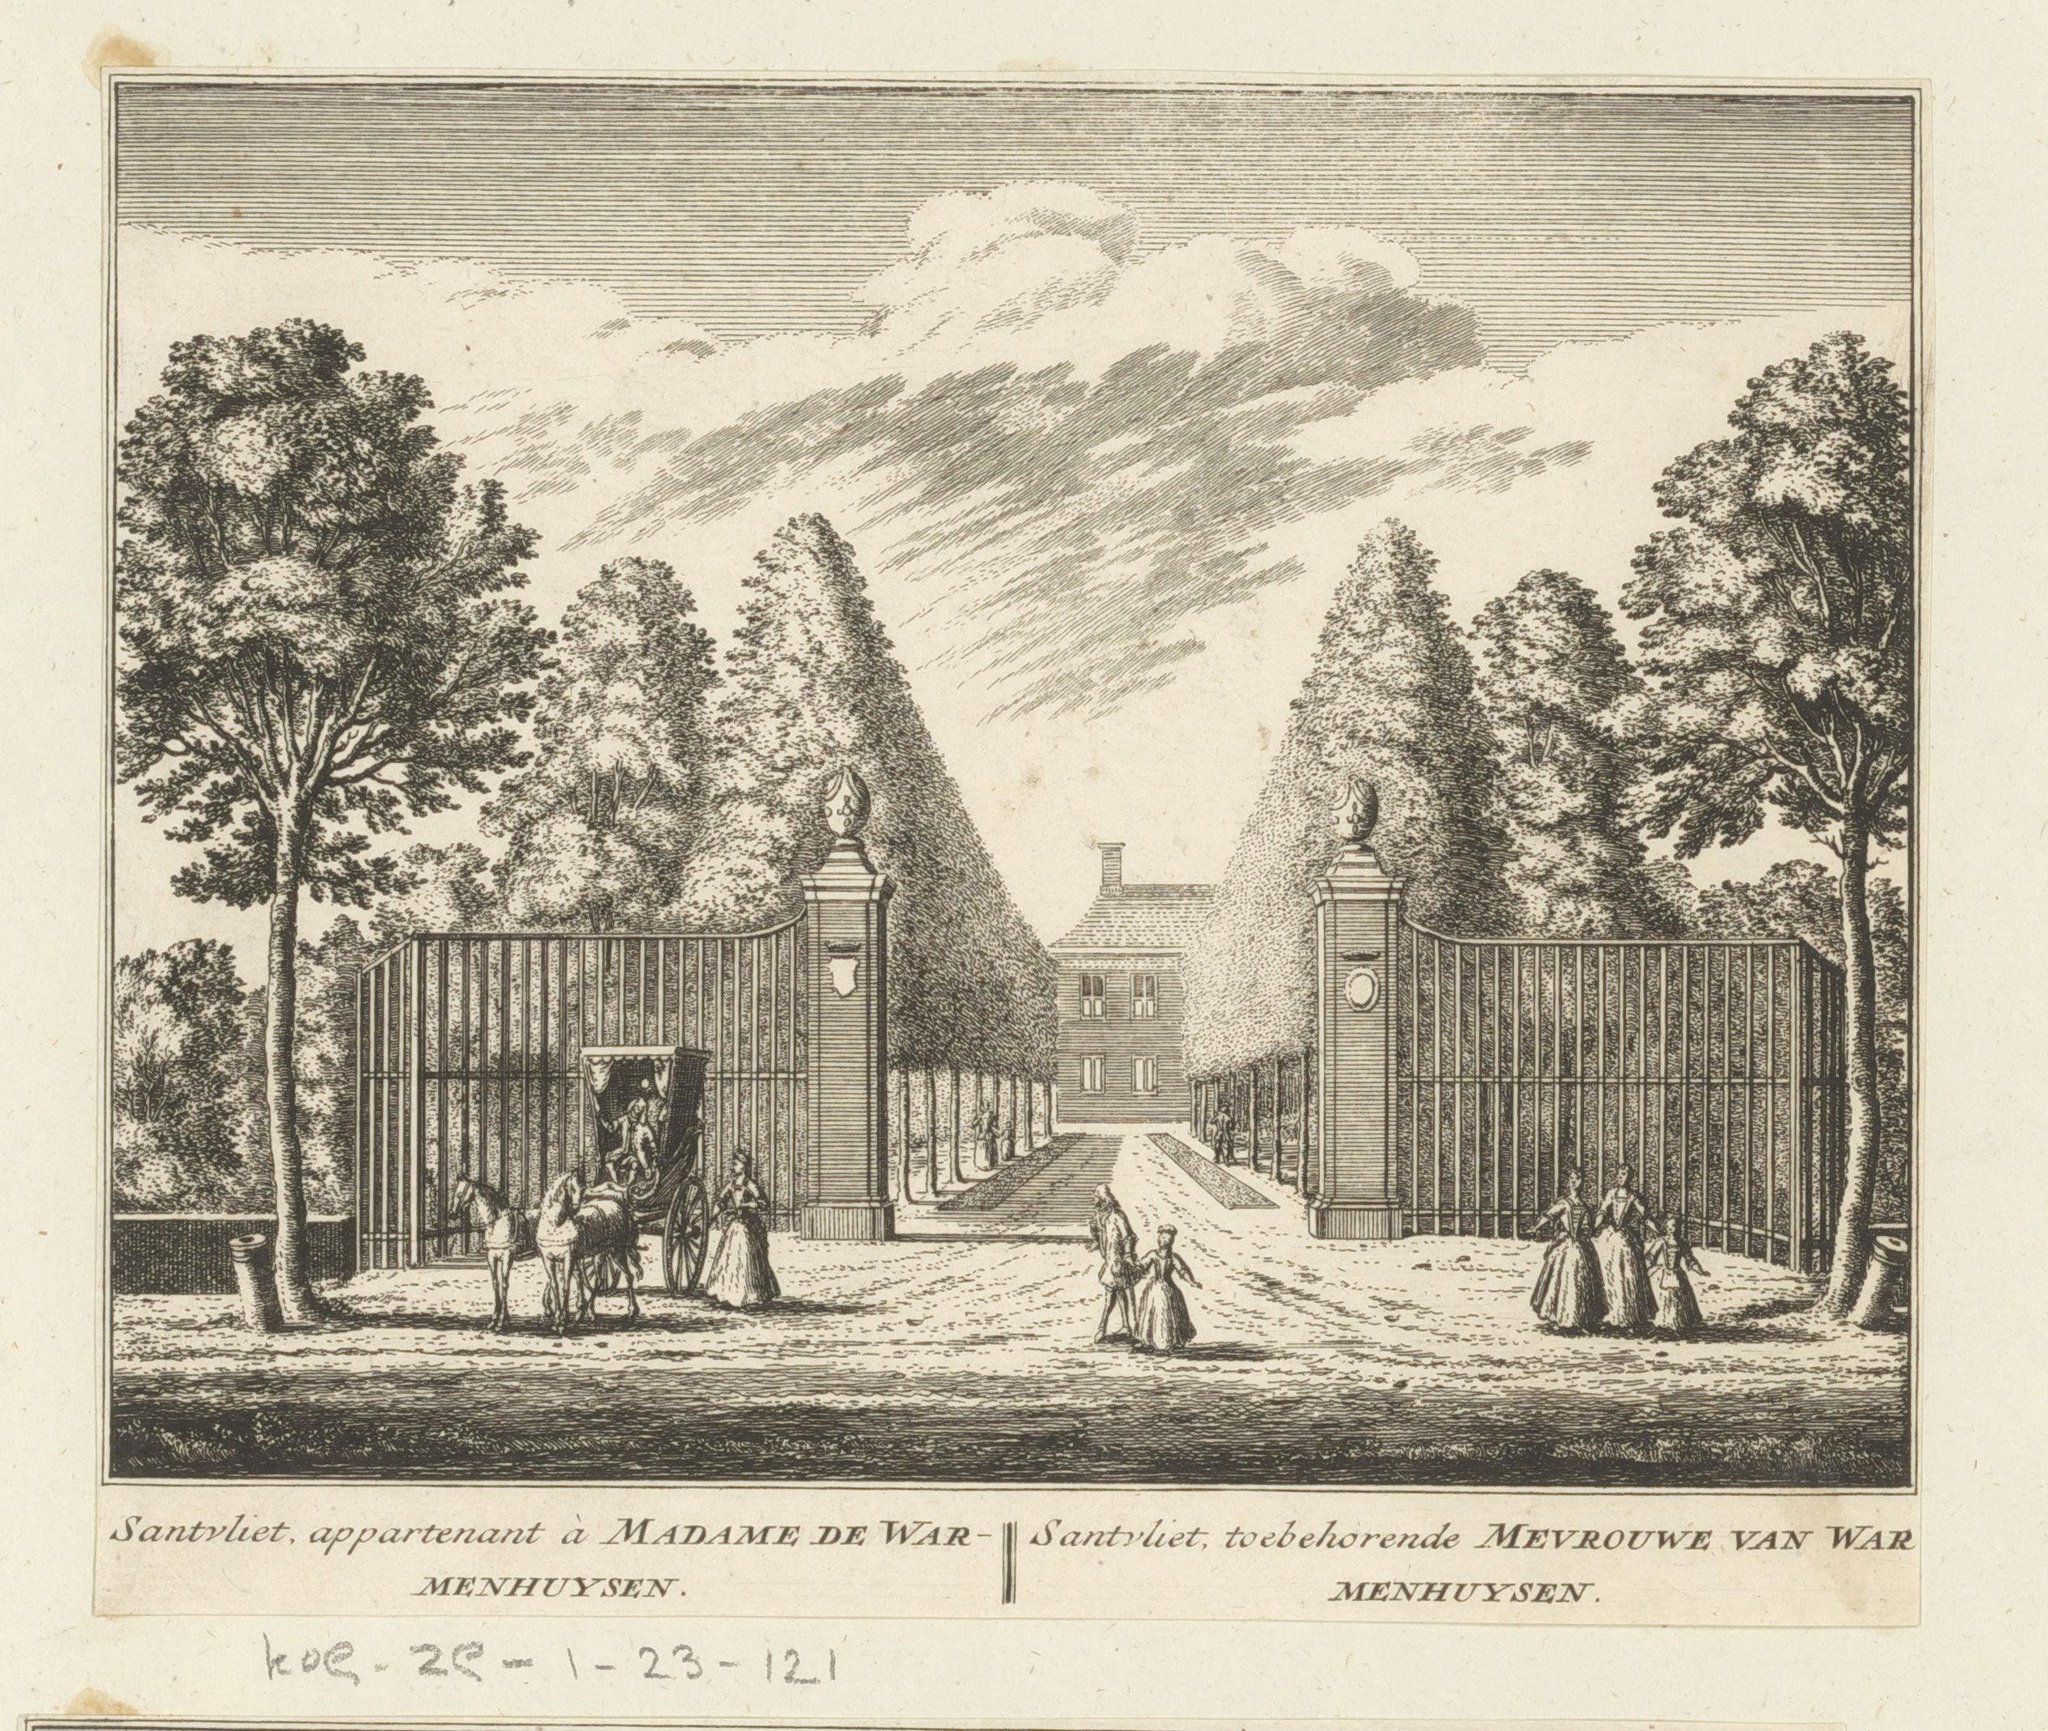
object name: print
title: Santvliet, appartenant à Madame de Warmenhuys / Santvliet, toebehorende Mevrouwe van Warmenhuys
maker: hendrik de leth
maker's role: draughtsman, print maker, publisher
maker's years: 1703-1766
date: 1732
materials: paper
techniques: engraving, etching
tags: two-wheeled, animal-drawn vehicle, gate, entrance, country-house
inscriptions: stamp, stamp, collector's mark: Lugt 1641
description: Prent waarschijnlijk uit: Broüerius van Nidek, Mattheus. Het Zegenpralent Kennemerlant, vertoont in veele Heerlijke Gezichten. Amsterdam: Leth, Hendrik de en Leth, Andries de, 1732, dl. 2.